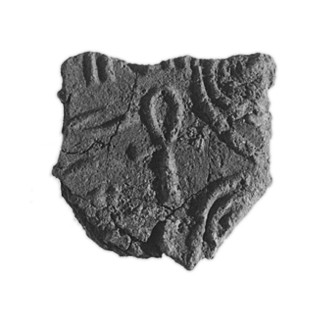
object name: sealing, administrative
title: Administrative Seal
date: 1981-1640 BCE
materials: clay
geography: egypt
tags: ankh